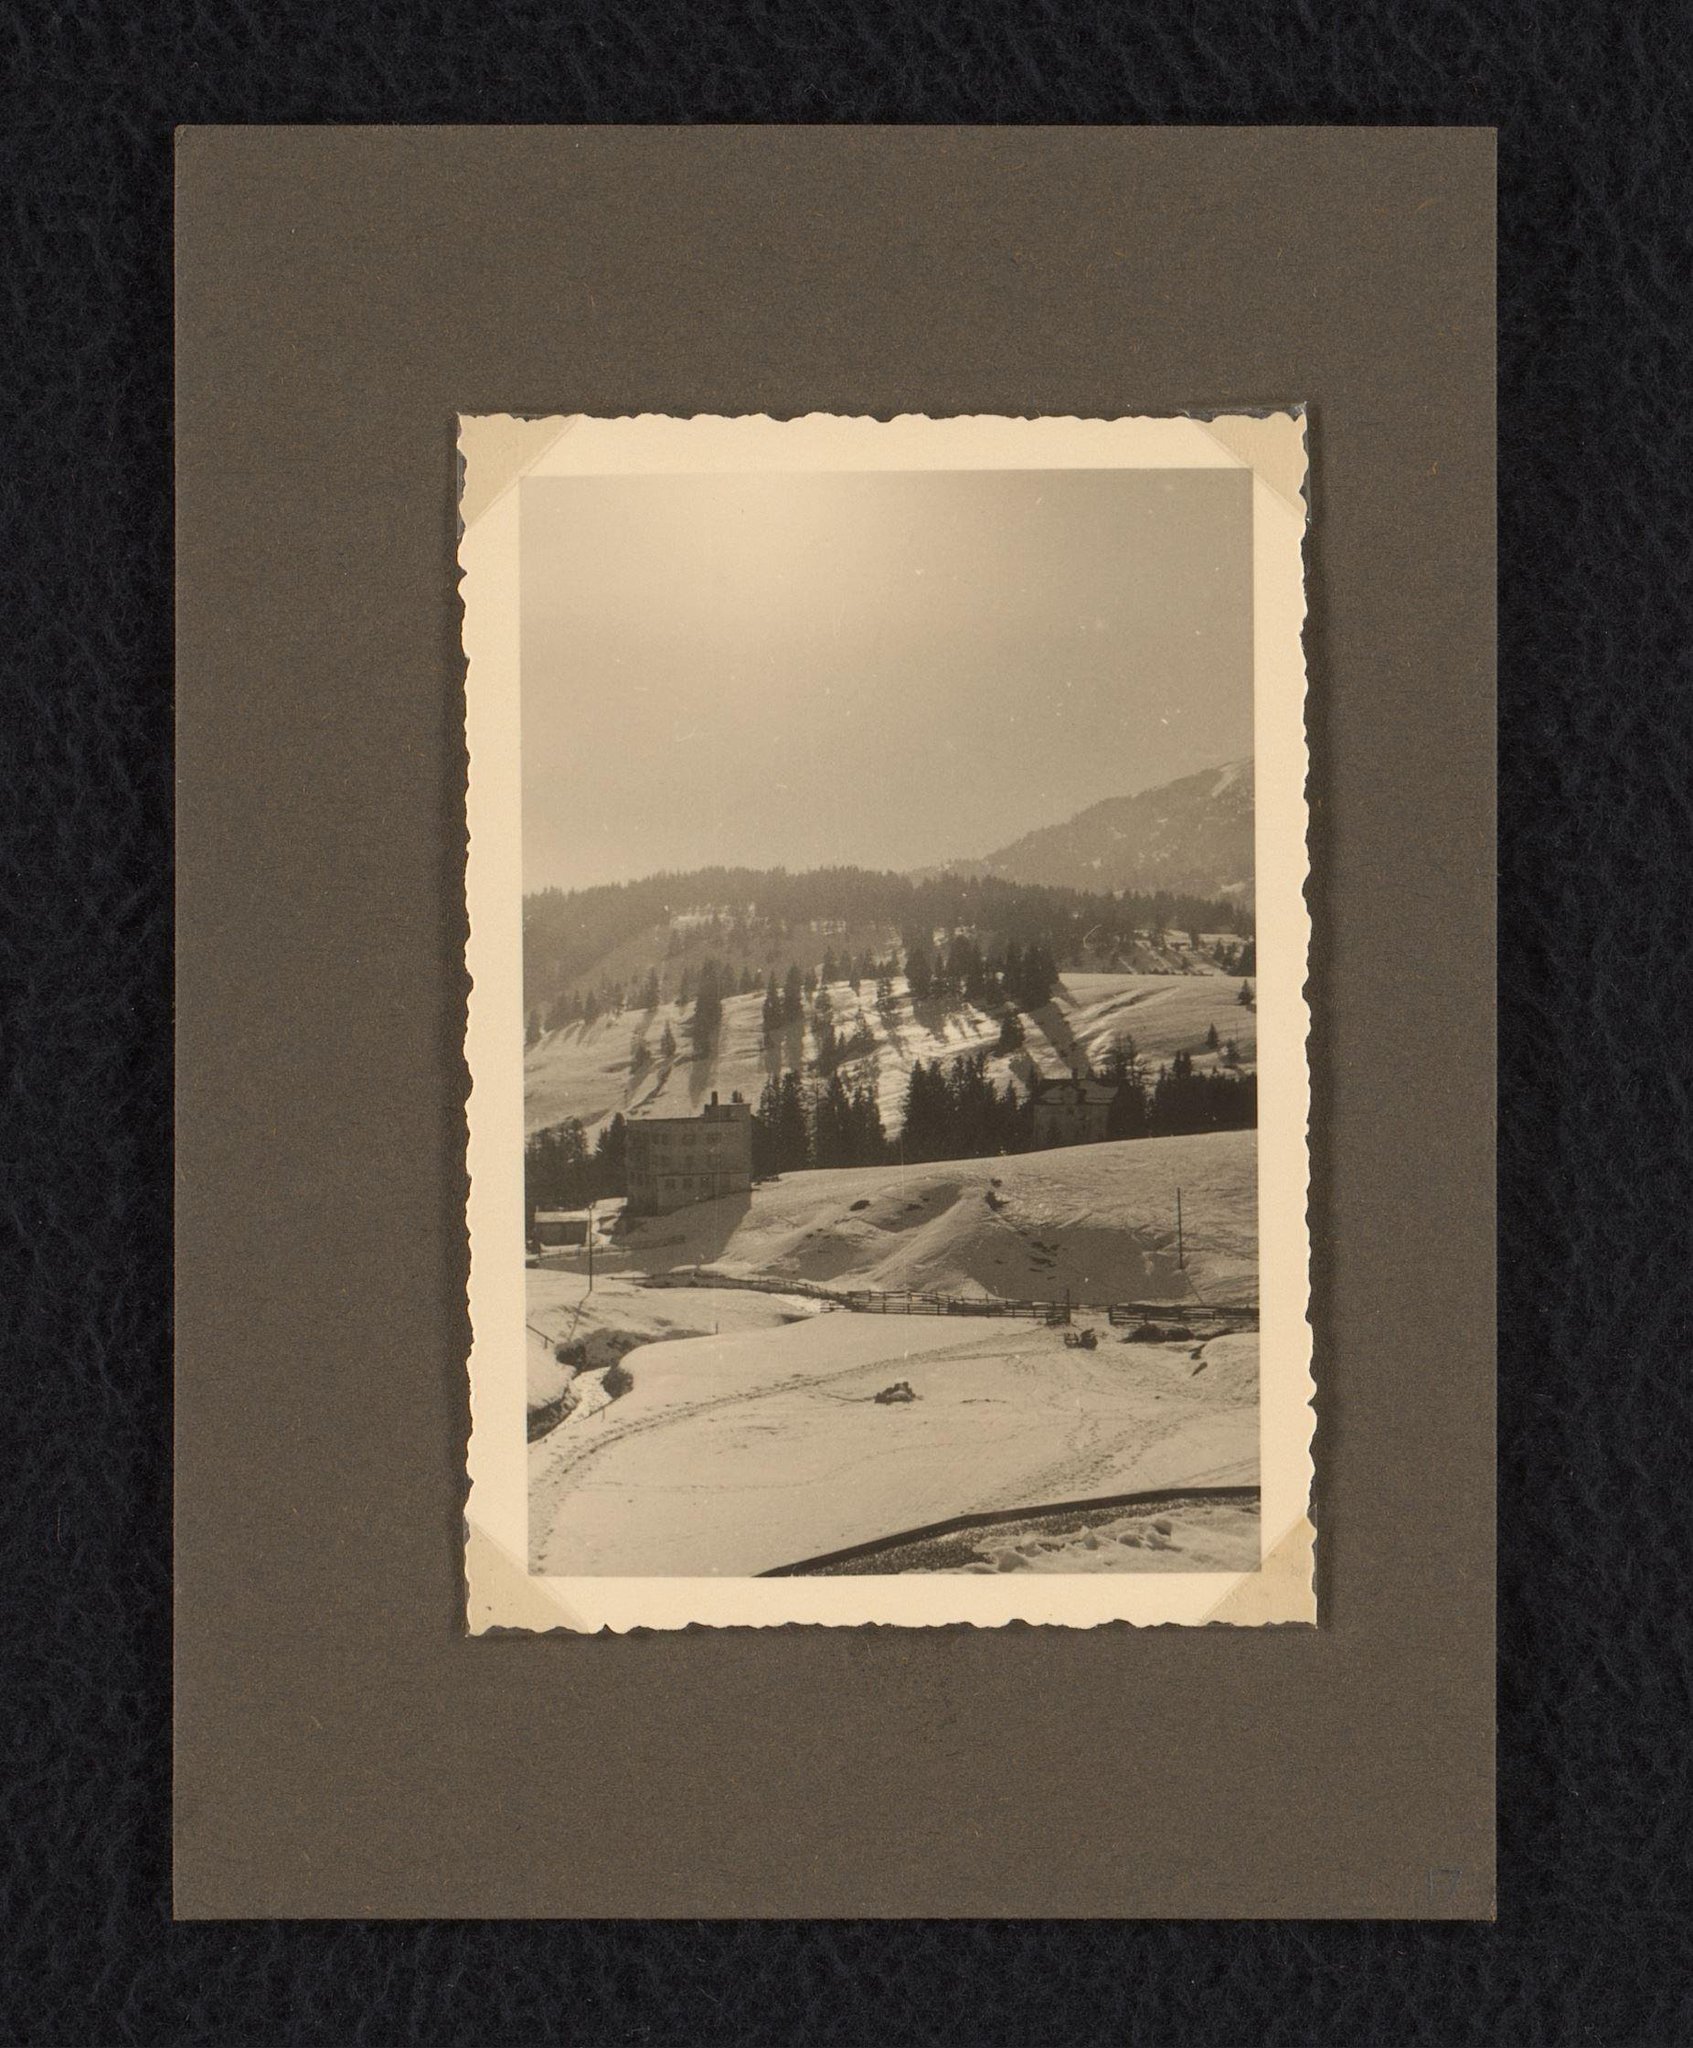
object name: photograph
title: Sneeuwlandschap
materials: cardboard, photographic support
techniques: gelatin silver print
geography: lenzerheide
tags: leiden, isabel wachenheimer-elon, the family travelling, on holiday, snow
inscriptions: date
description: Albumblad met een foto van een sneeuwlandschap. Onderdeel van het fotoalbum met vakantiefoto's Lenzerheide, 1934.